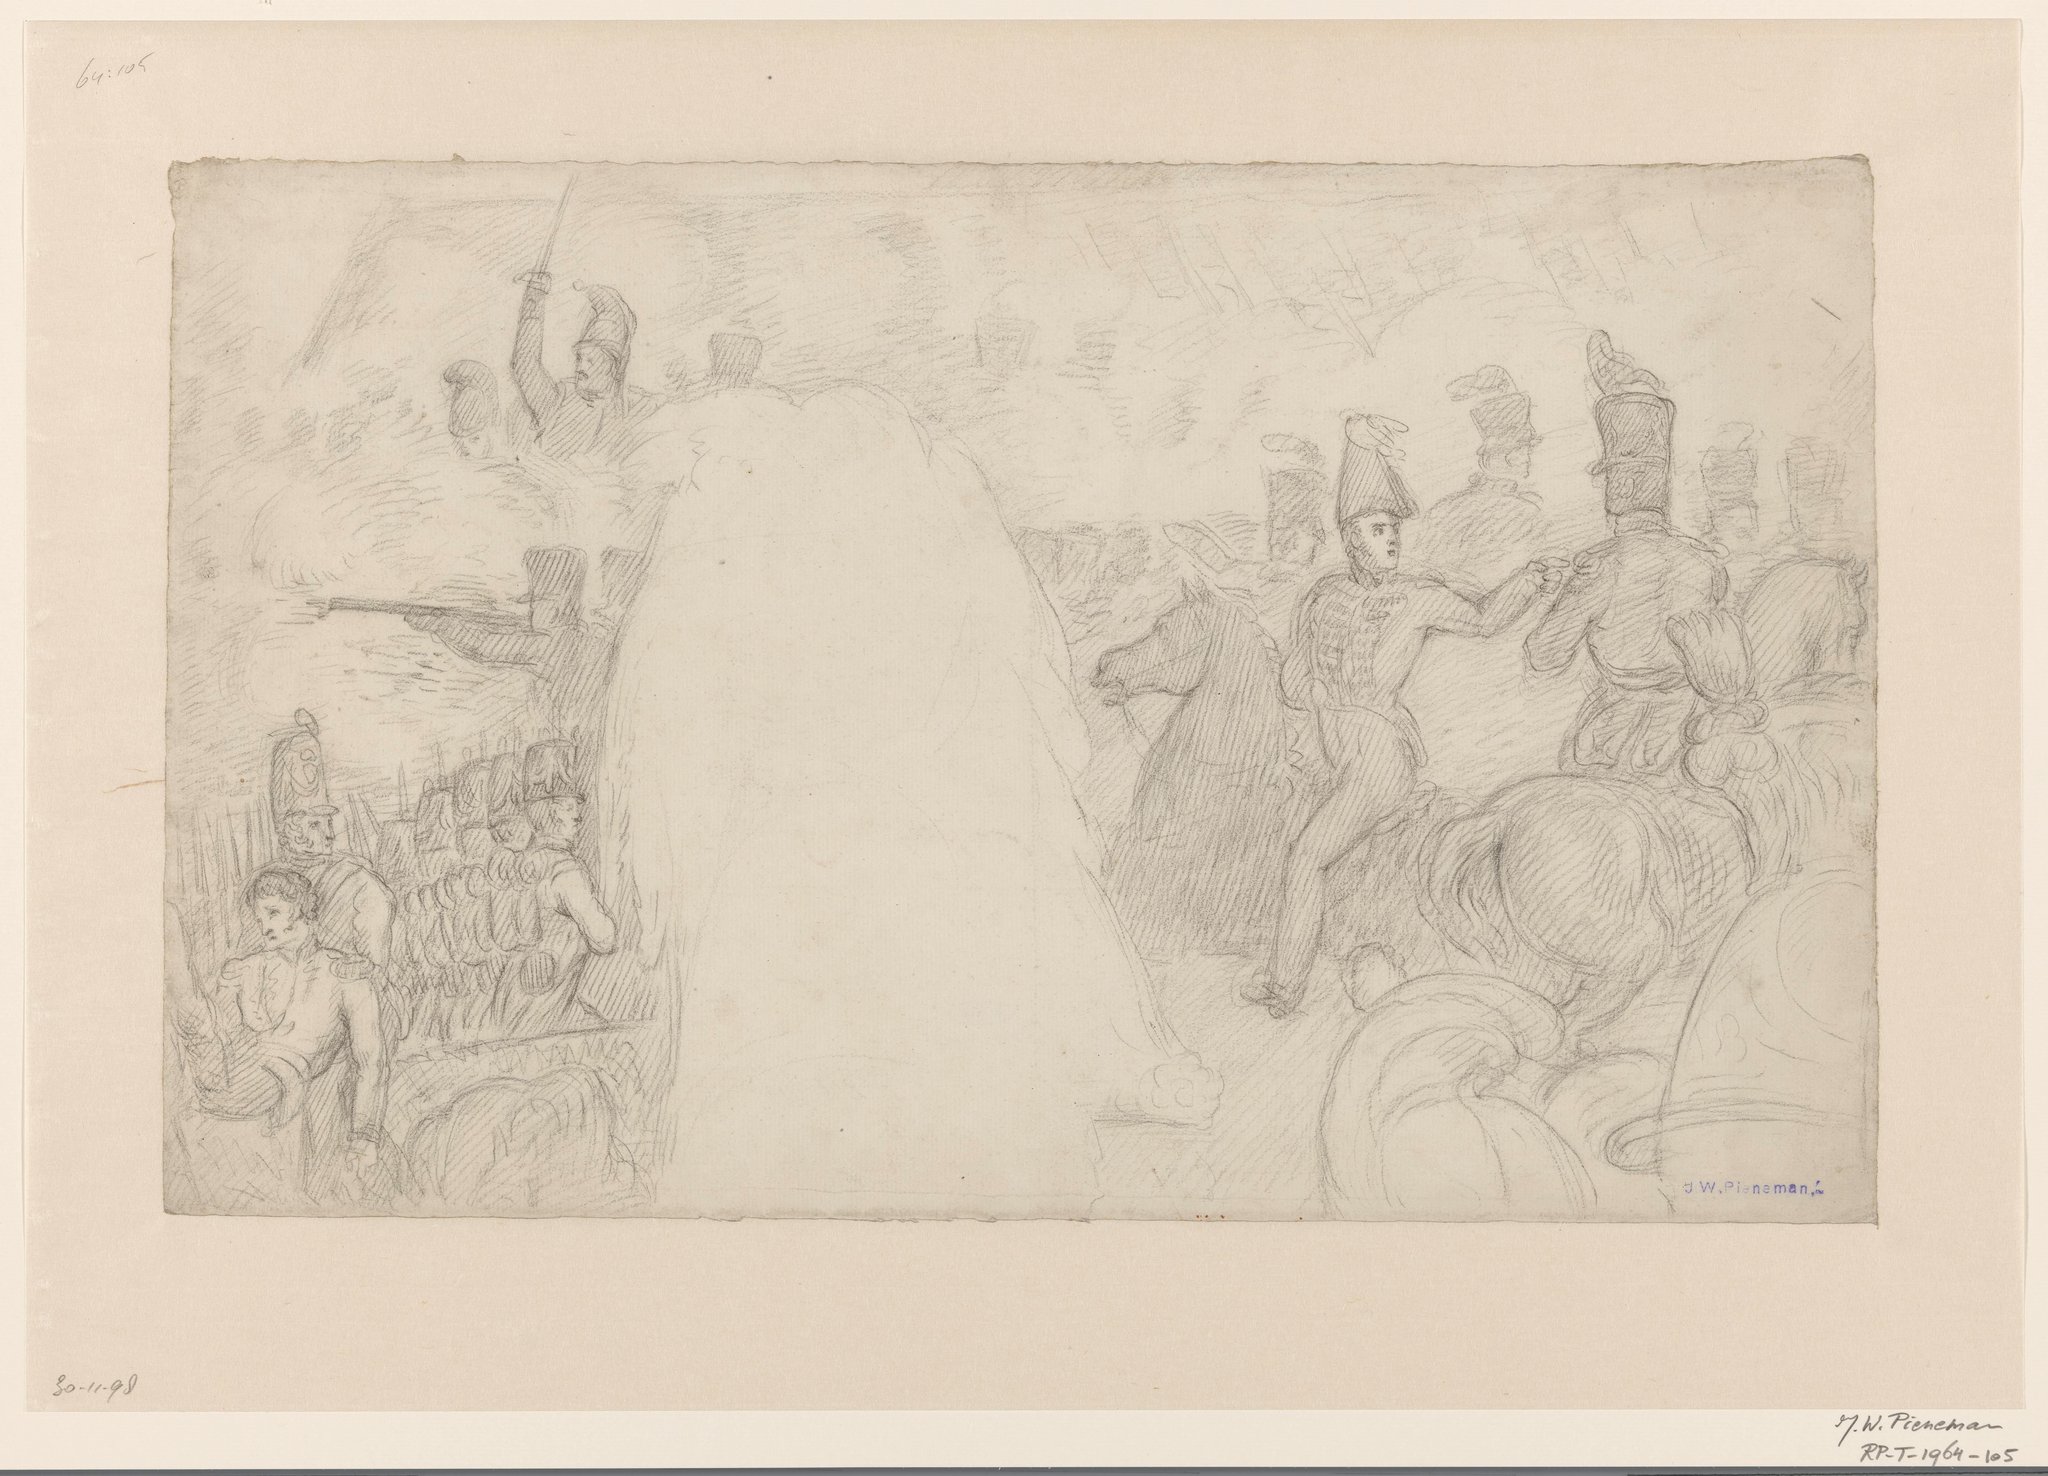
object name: drawing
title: Detail uit het schilderij De Slag bij Waterloo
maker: jan willem pieneman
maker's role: draughtsman, painter, print maker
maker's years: 1779-1853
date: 1789-1853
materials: chalk, paper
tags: battle (+ land forces), historical events and situations